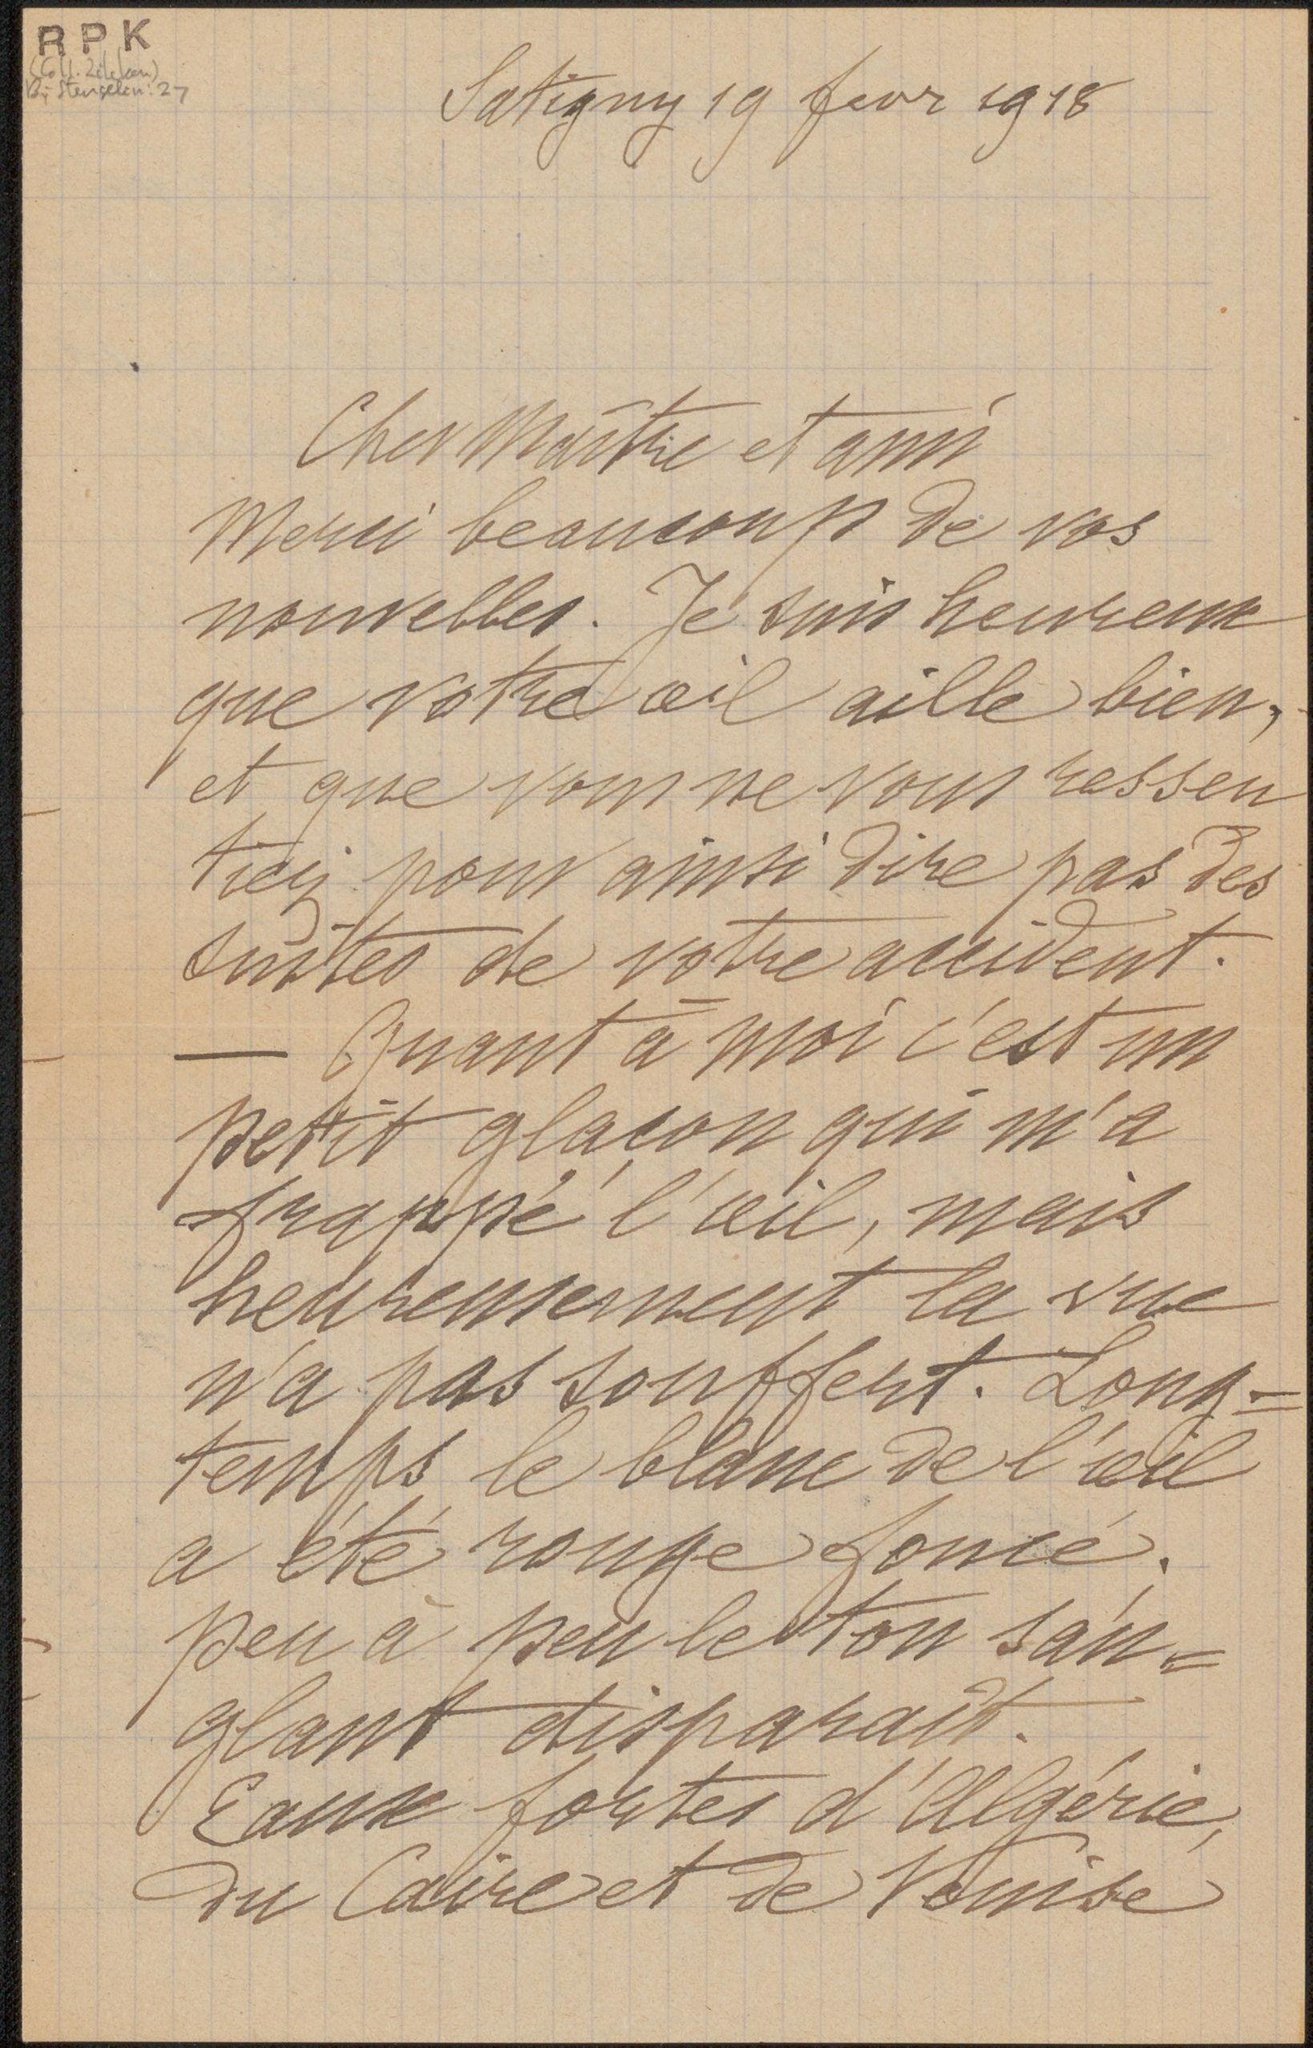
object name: letter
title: Brief aan Philip Zilcken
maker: alphonse stengelin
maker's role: painter, print maker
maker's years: 1852-1938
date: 1918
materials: ink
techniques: pen, writing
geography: satigny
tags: roger louis de oberkampf dabrun, painter, draughtsman, philip zilcken, drawing, the graphic arts, artist at work, in his workshop - bb - out of doors, netherlands, venice, switzerland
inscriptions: collector's mark: ‘RPK’